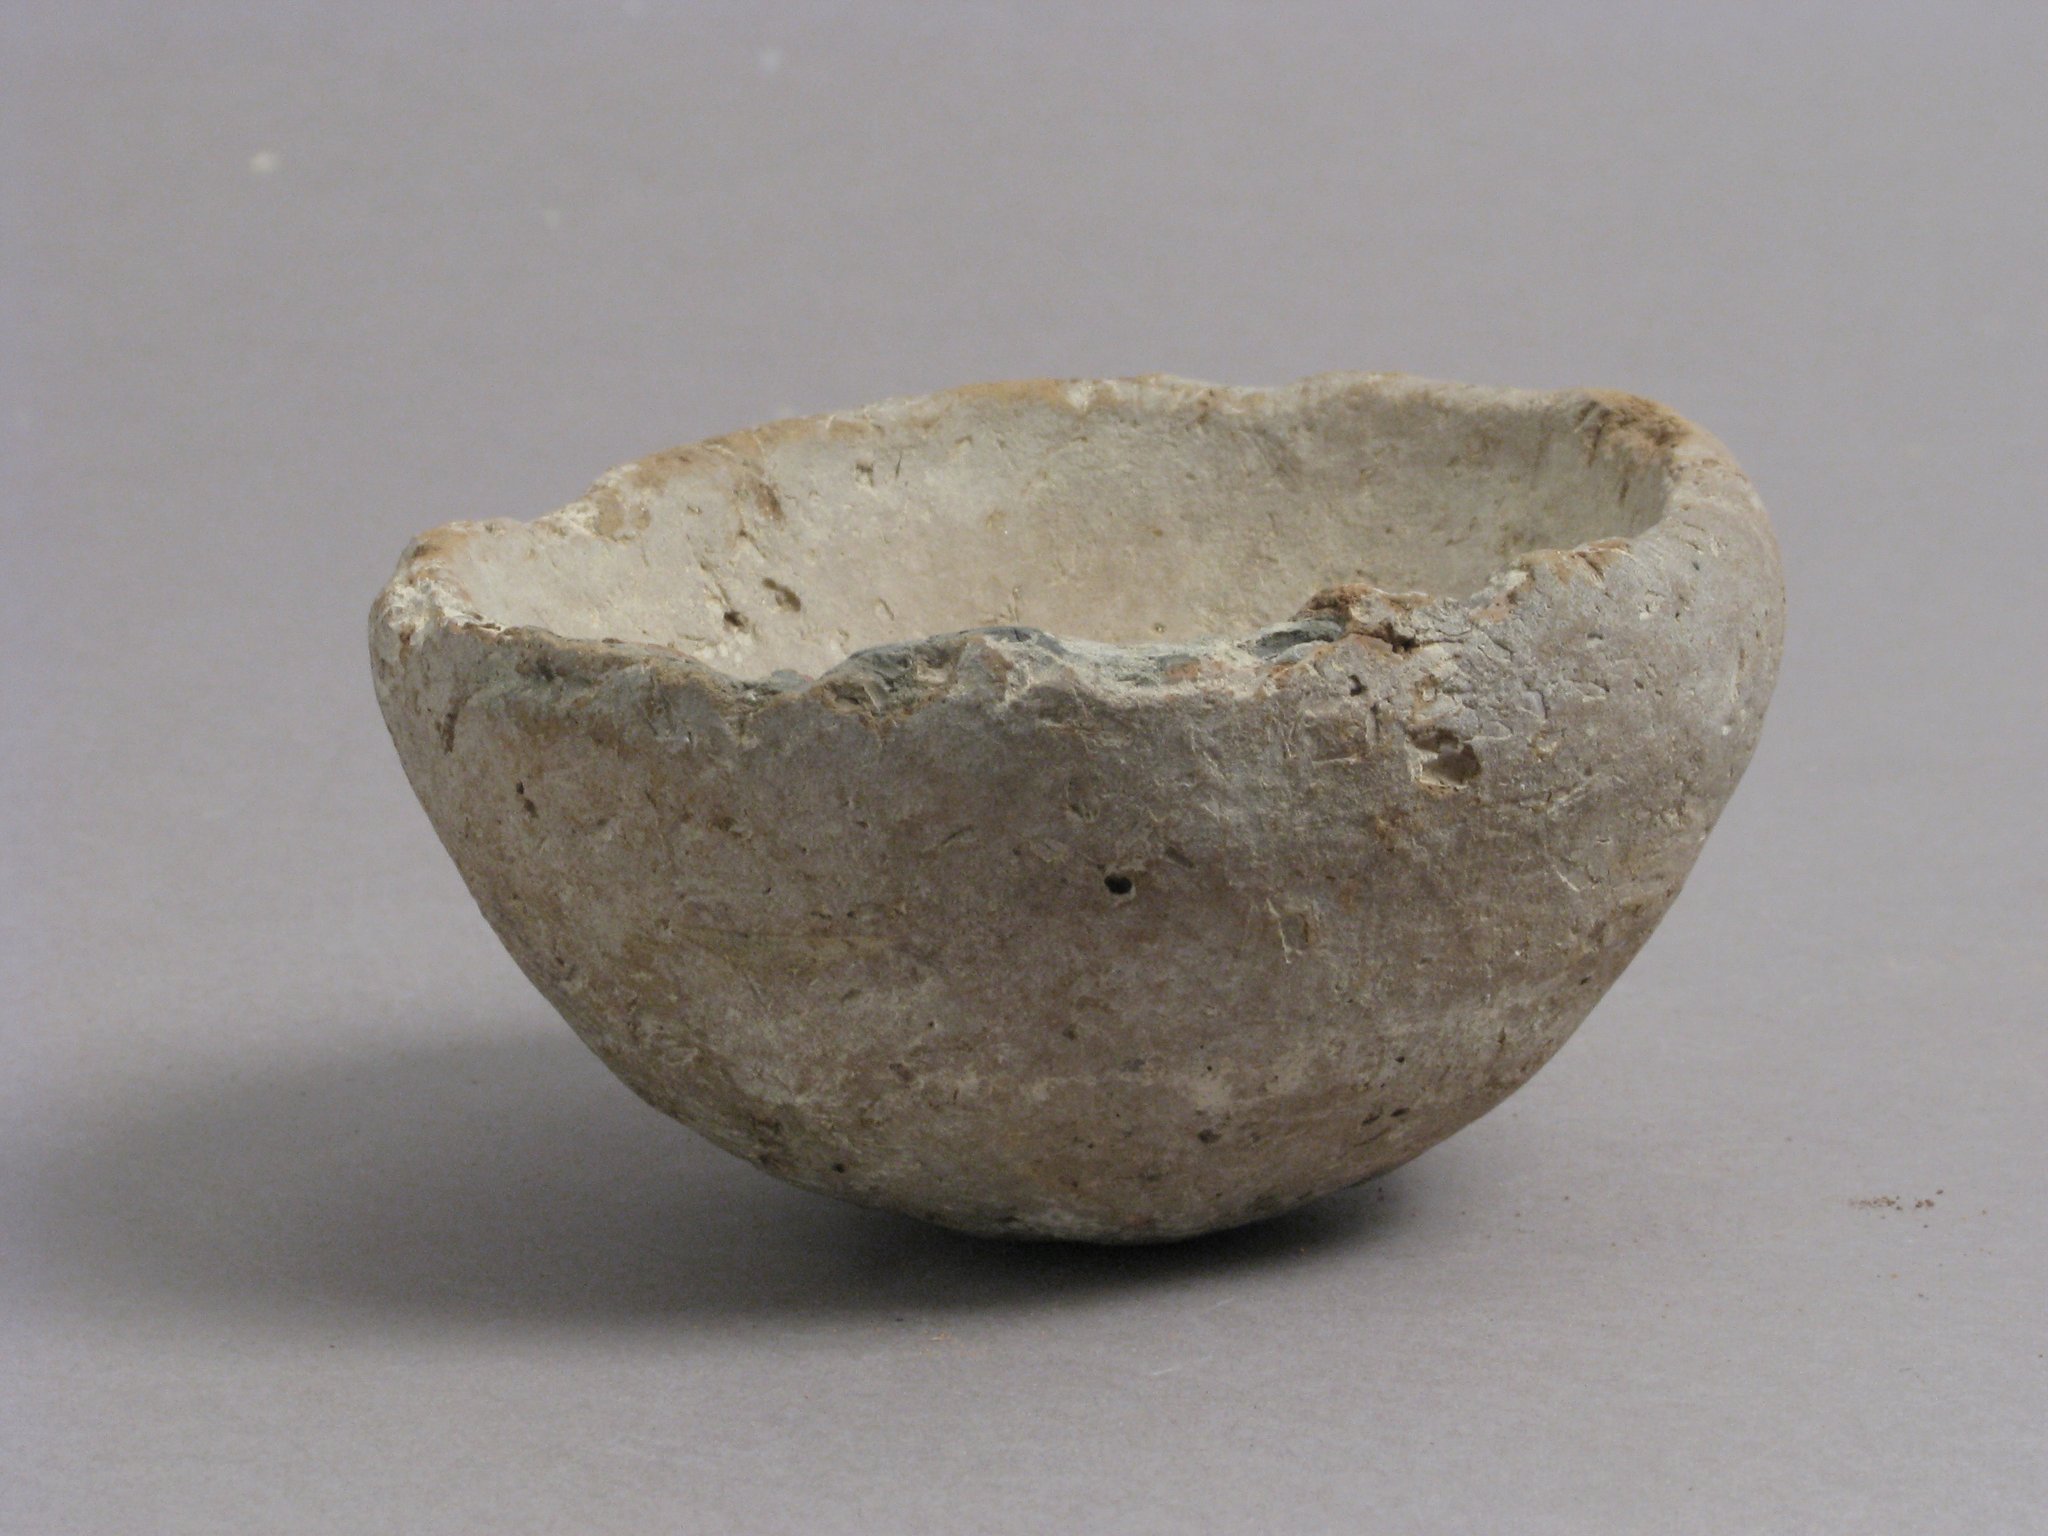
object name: bowl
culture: coptic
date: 301-700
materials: earthenware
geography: egypt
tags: bowls